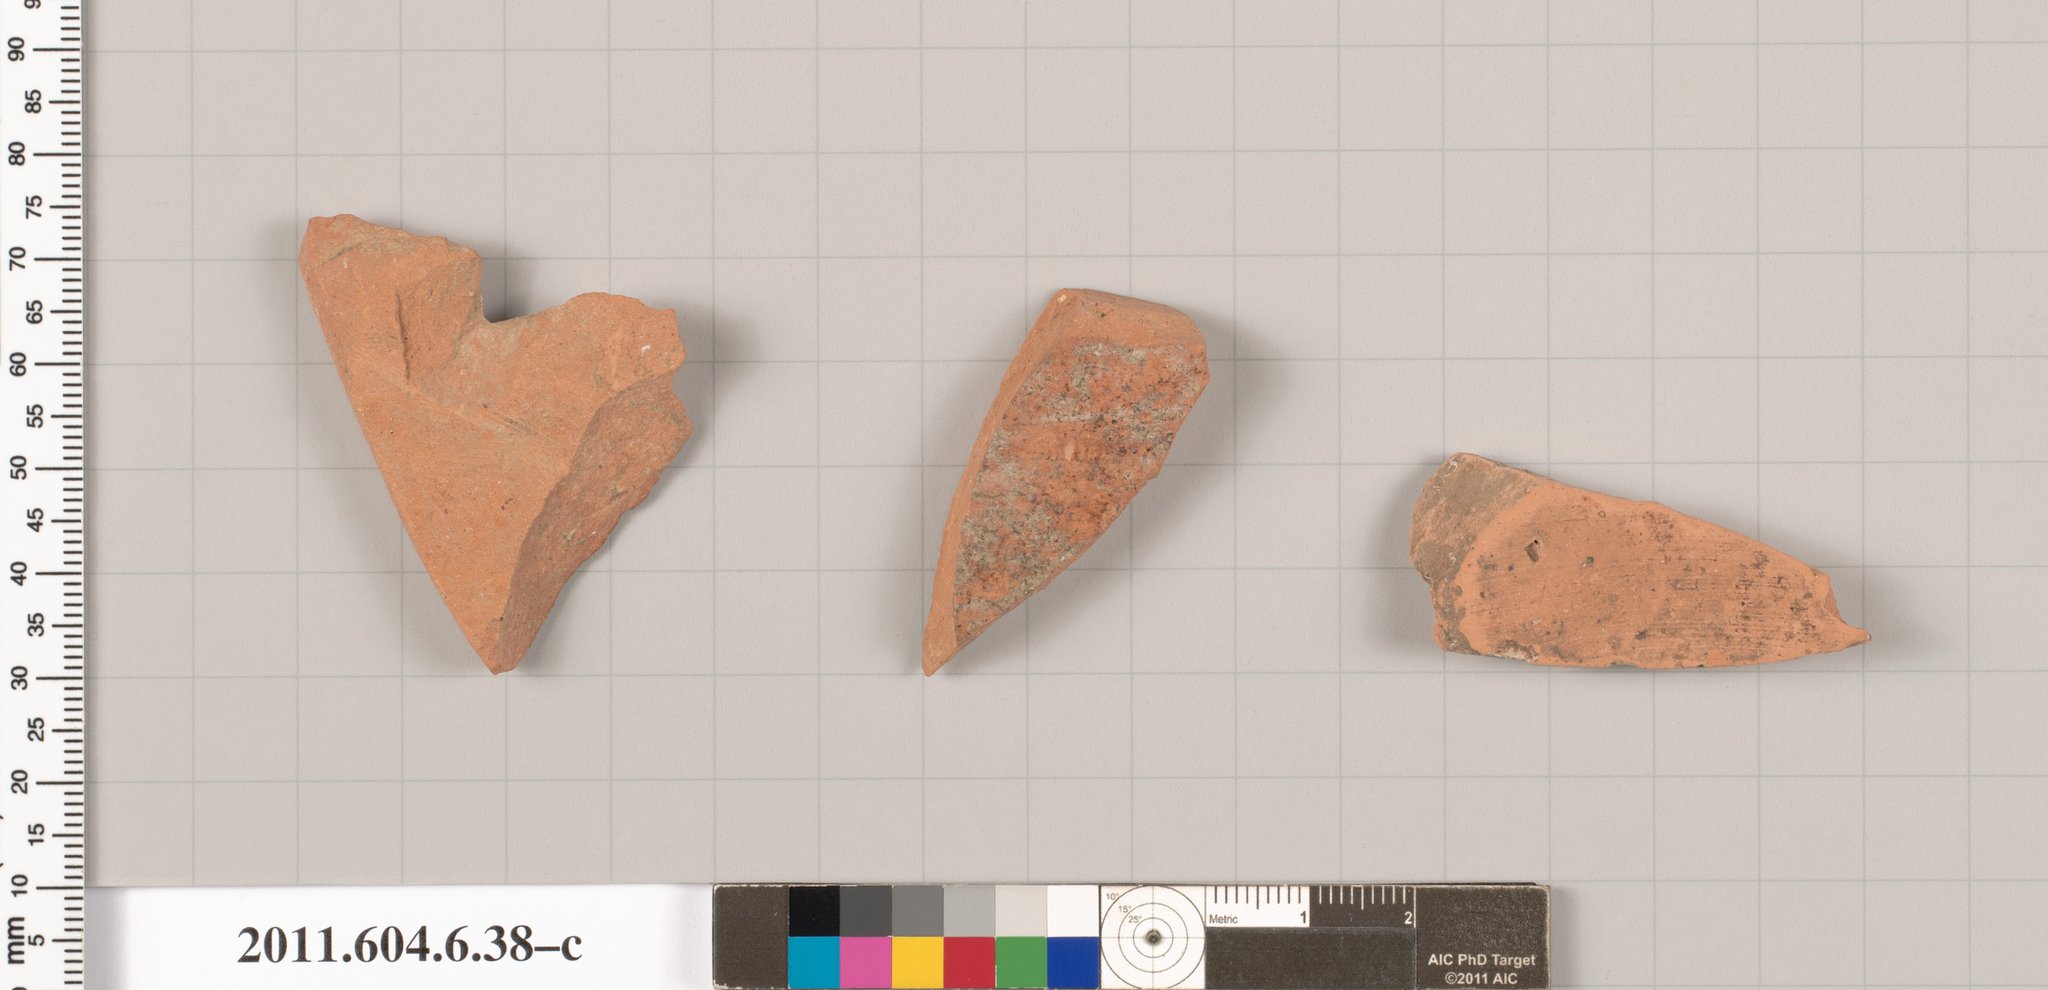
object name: undetermined closed shape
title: Terracotta fragments of closed shapes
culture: greek, attic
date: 600-401 BCE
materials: terracotta